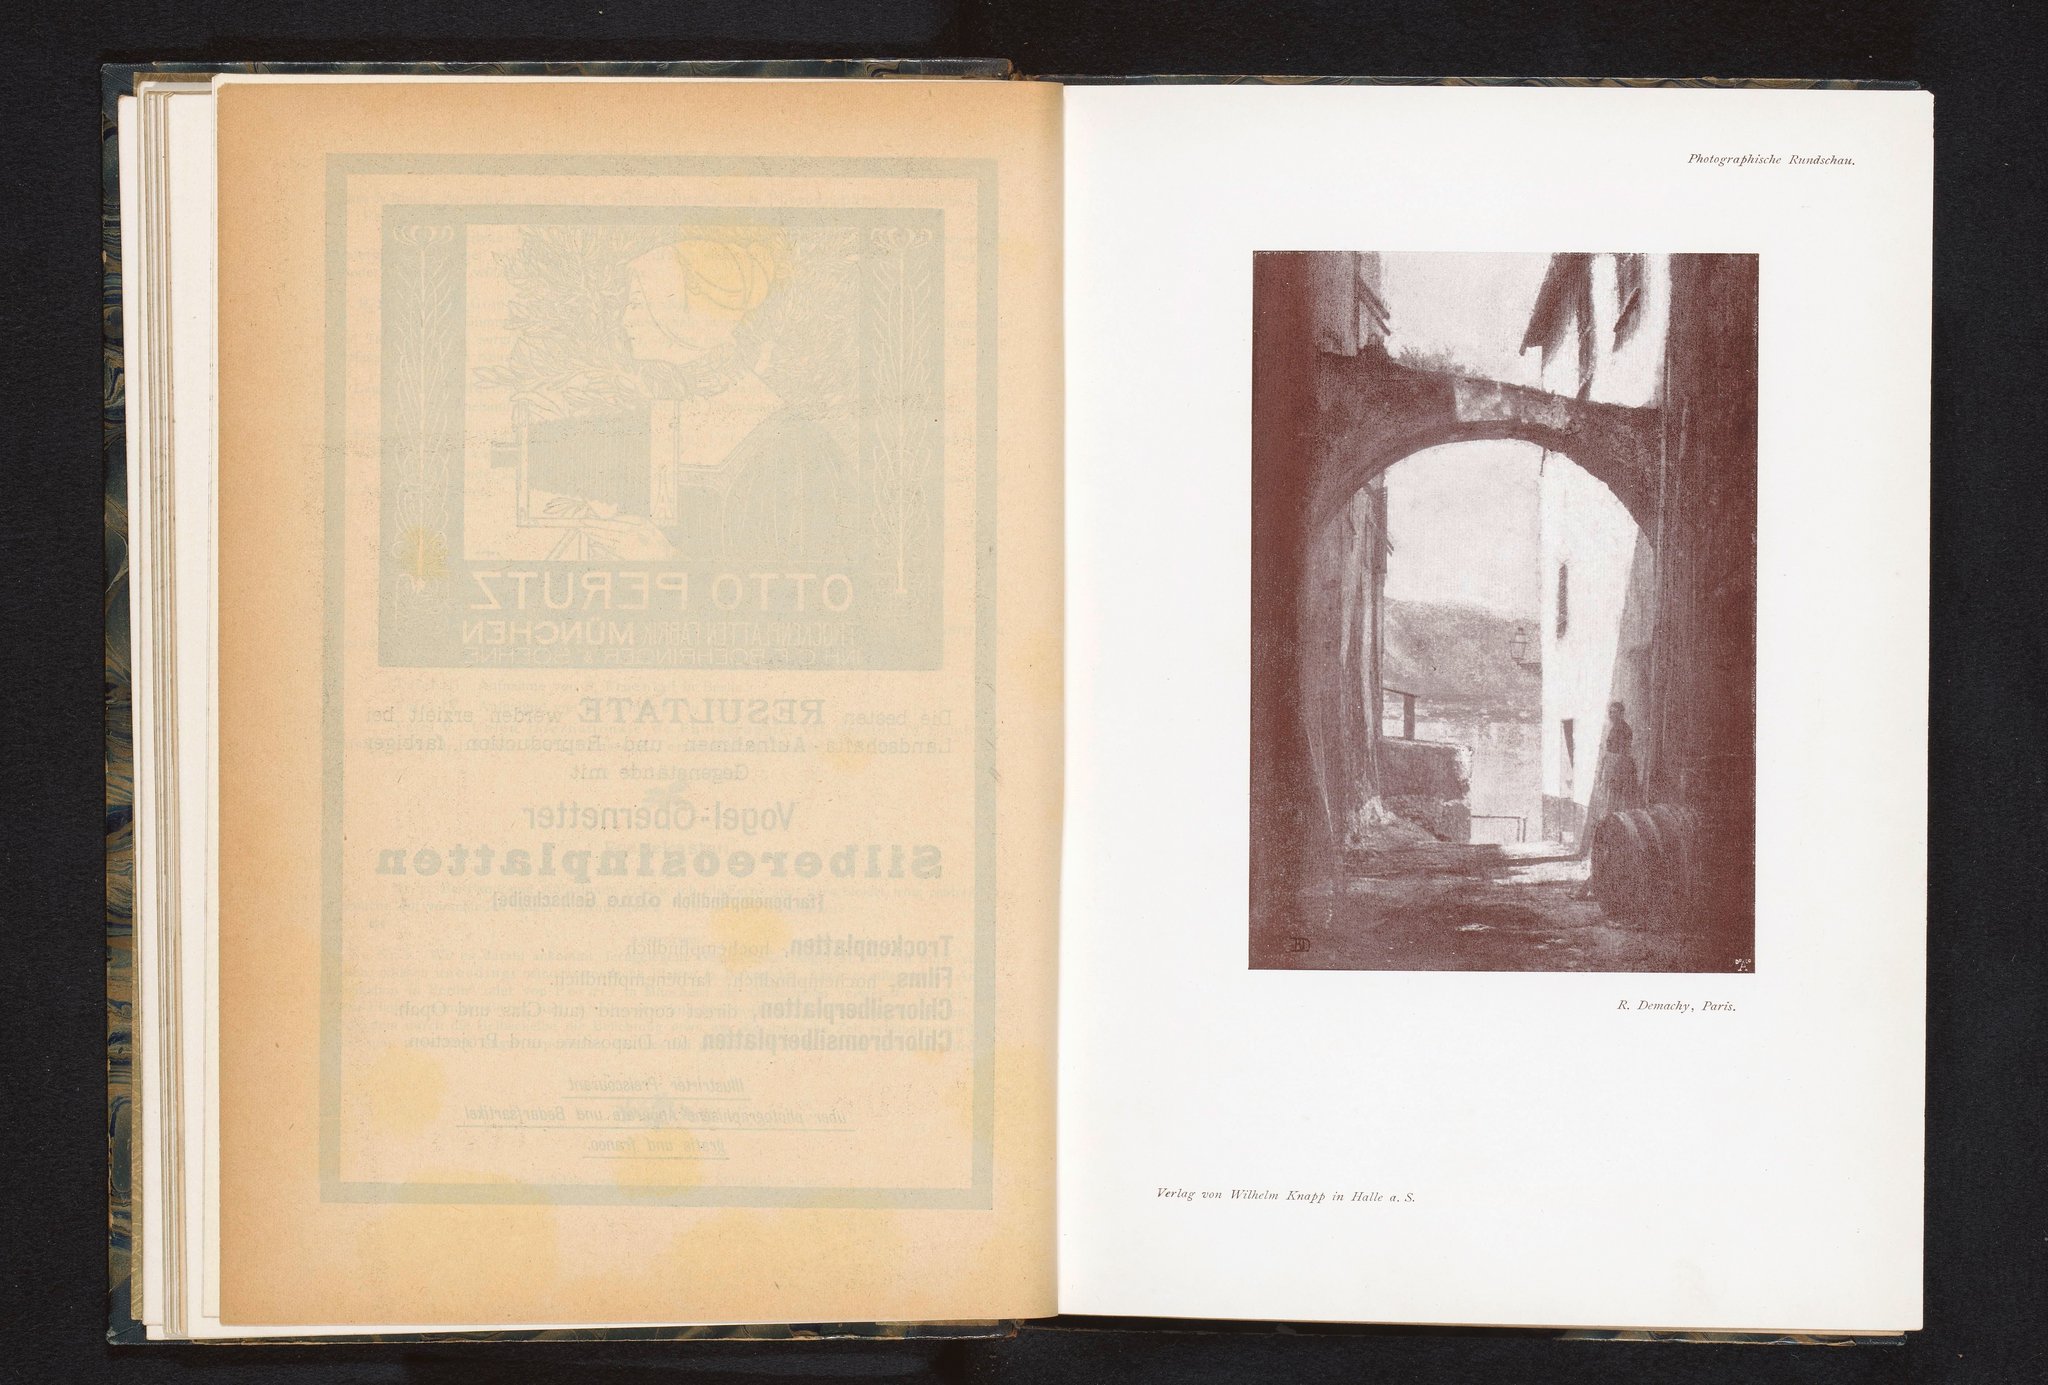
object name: page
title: Fotoreproductie van een tekening of schilderij van een poortje tussen twee straten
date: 1895-1900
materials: paper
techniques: autotype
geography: halle an der saale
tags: street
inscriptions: monogram: ‘drAco’